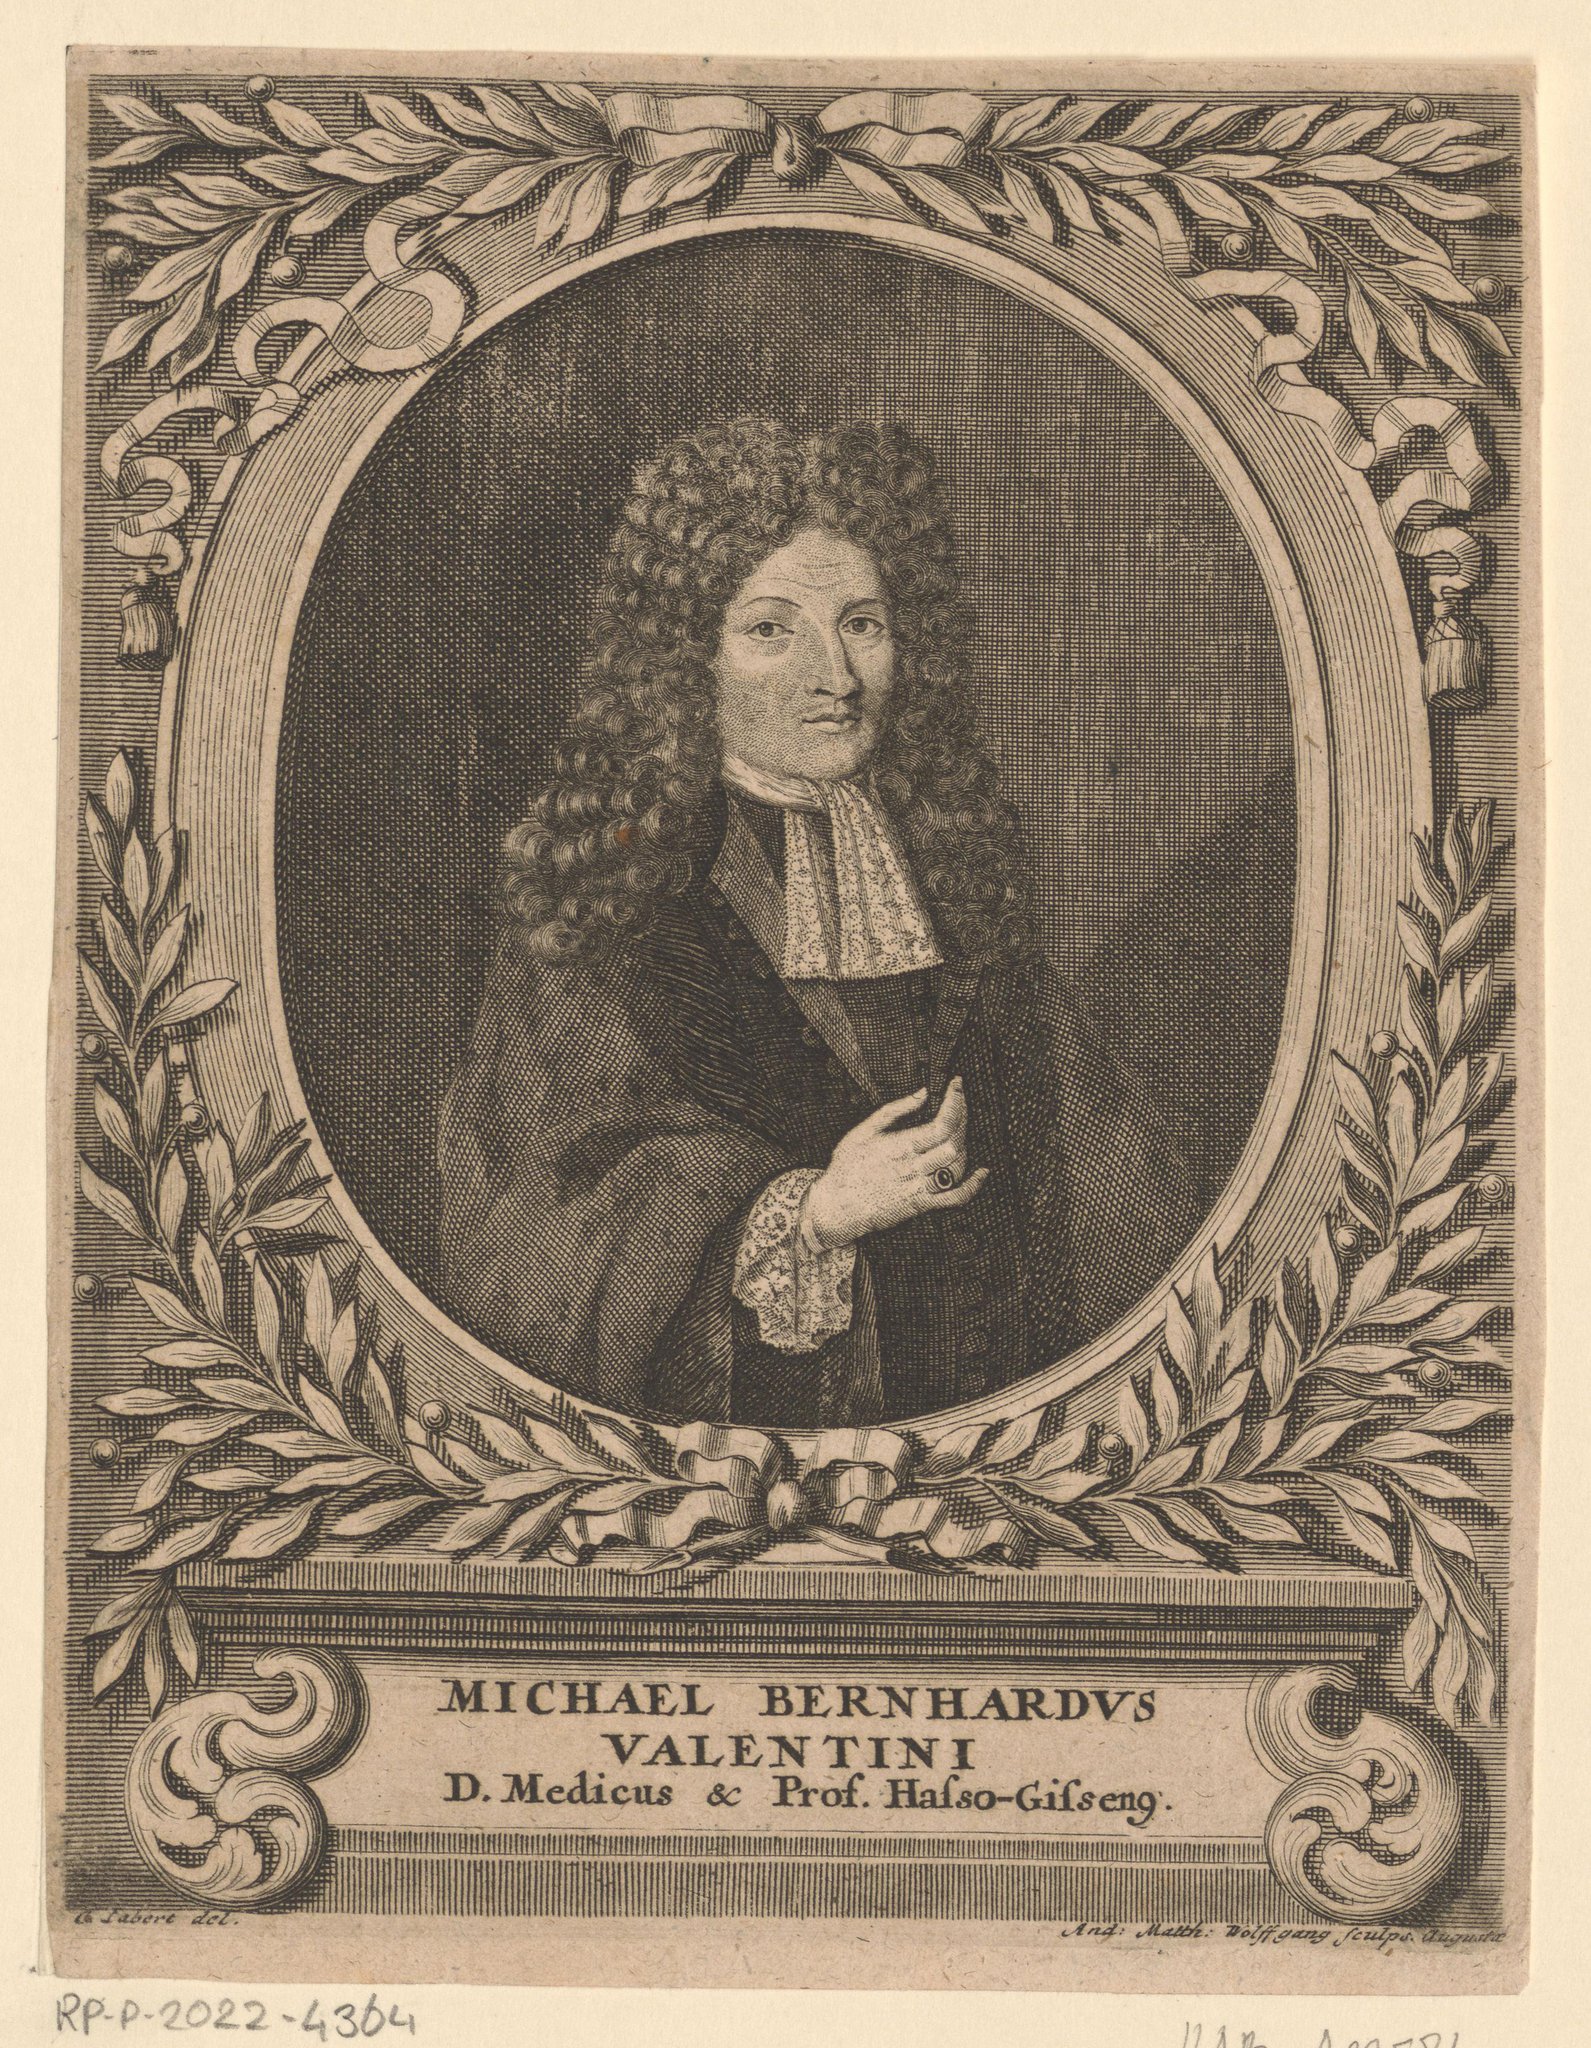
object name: print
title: Portret van Michael Bernhard Valentini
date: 1701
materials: paper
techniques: engraving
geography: augsburg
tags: historical persons, physician, doctor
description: Prent waarschijnlijk uit: Valentini, Michael Bernhard. Pandectae medico-legales, sive Responsa medico-forensia (...). Frankfurt am Main: Johann David Zunner, 1701.